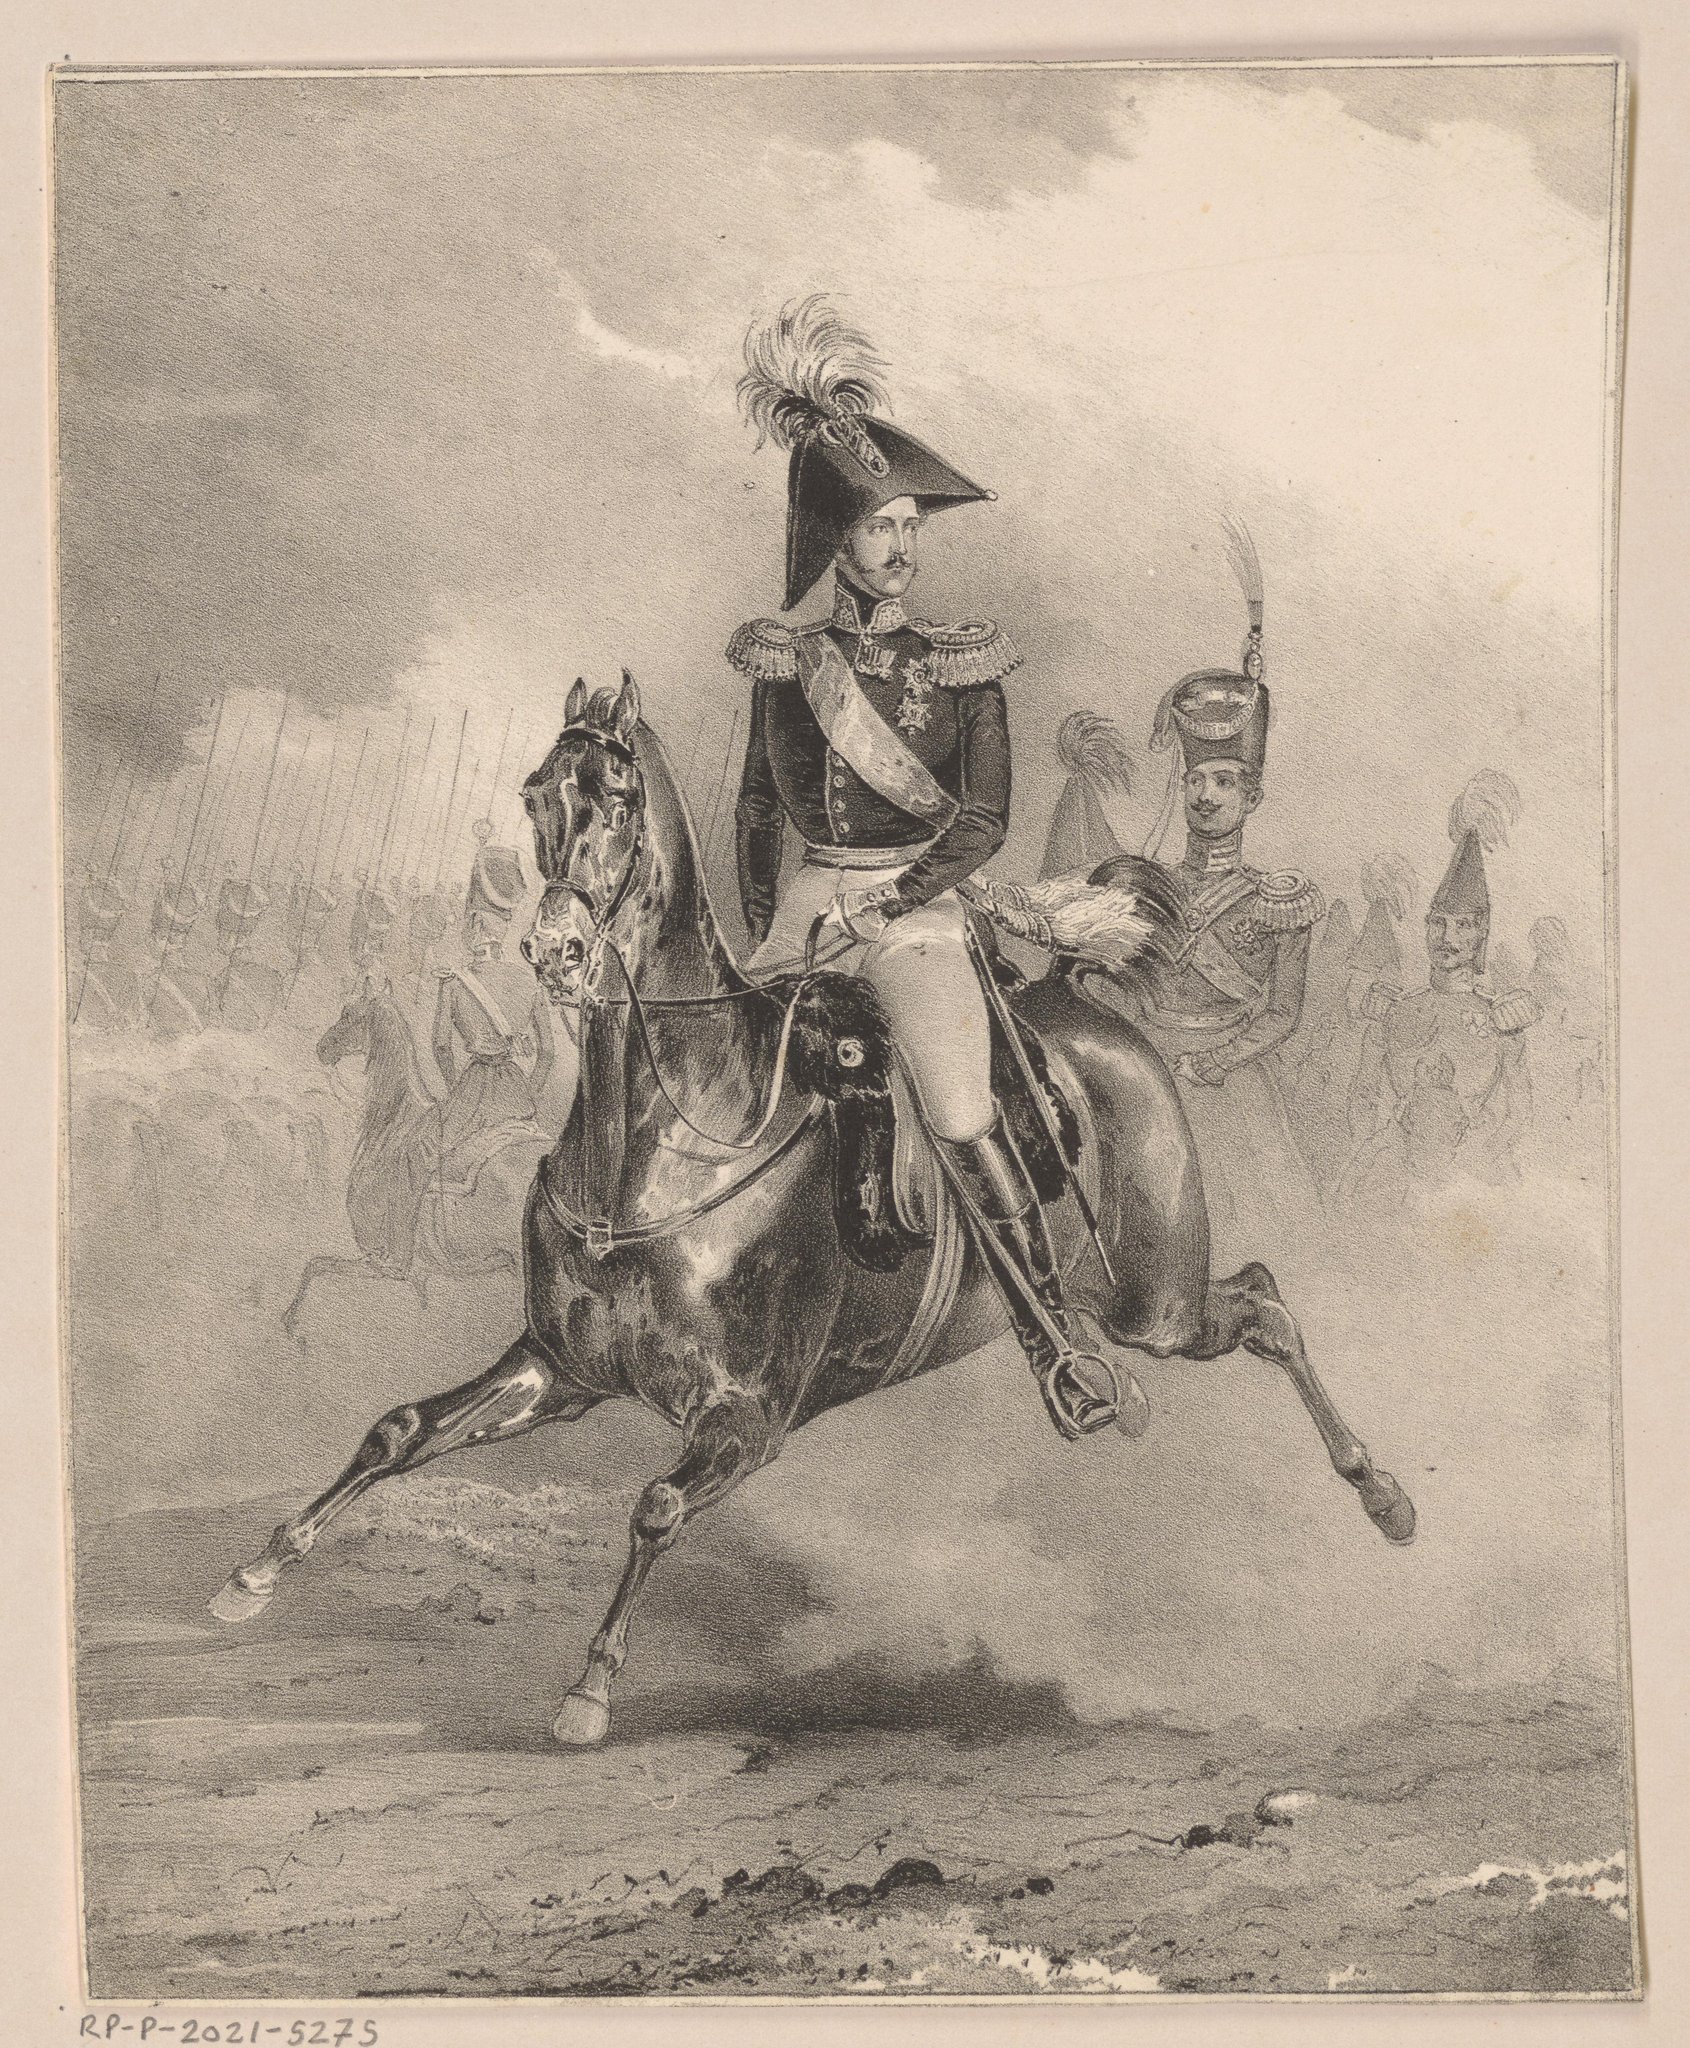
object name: print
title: Portret van Nicolaas I Pavlovitsj, tsaar van Rusland te paard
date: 1825-1899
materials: paper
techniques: lithograph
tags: riding a horse, ass, or mule; rider, horseman, knighthood order, historical persons, emperor, warfare; military affairs